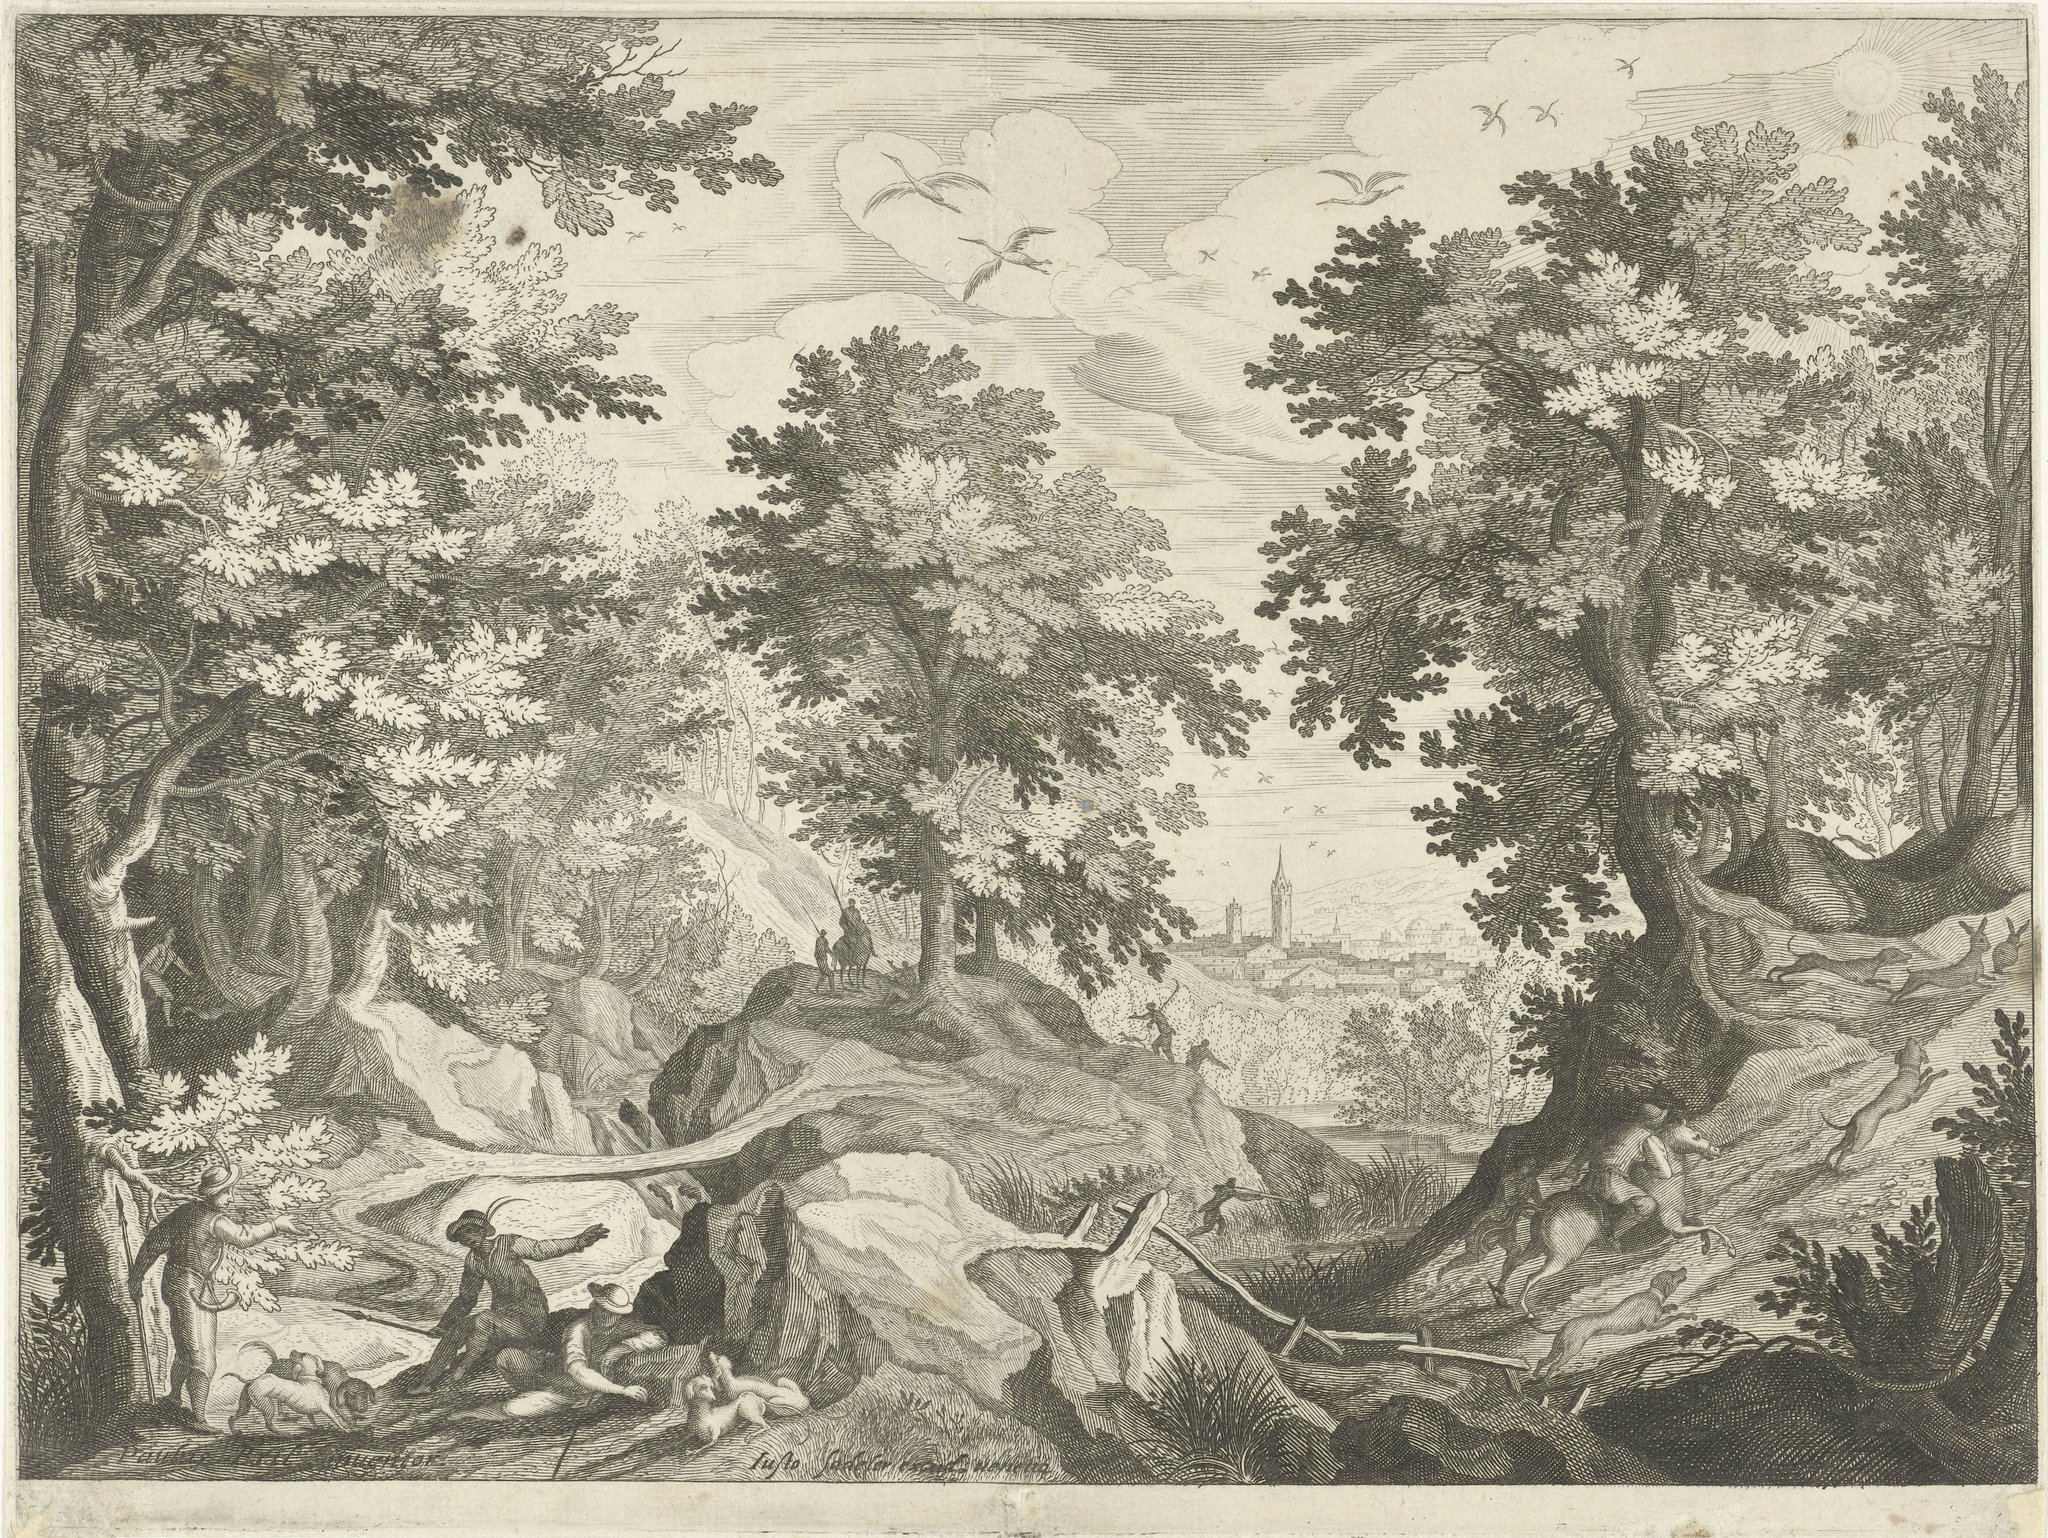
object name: print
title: Boslandschap met een hazenjacht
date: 1600-1620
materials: paper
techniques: engraving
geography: venice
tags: rodents: hare, forest, wood, hunt ~ mammals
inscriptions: collector's mark: Lugt 240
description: Heuvelachtig boslandschap met een hazenjacht. Op de voorgrond links enkele jagers met jachthonden. Rechts gaat een ruiter achter een haas aan samen met zijn jachthonden.